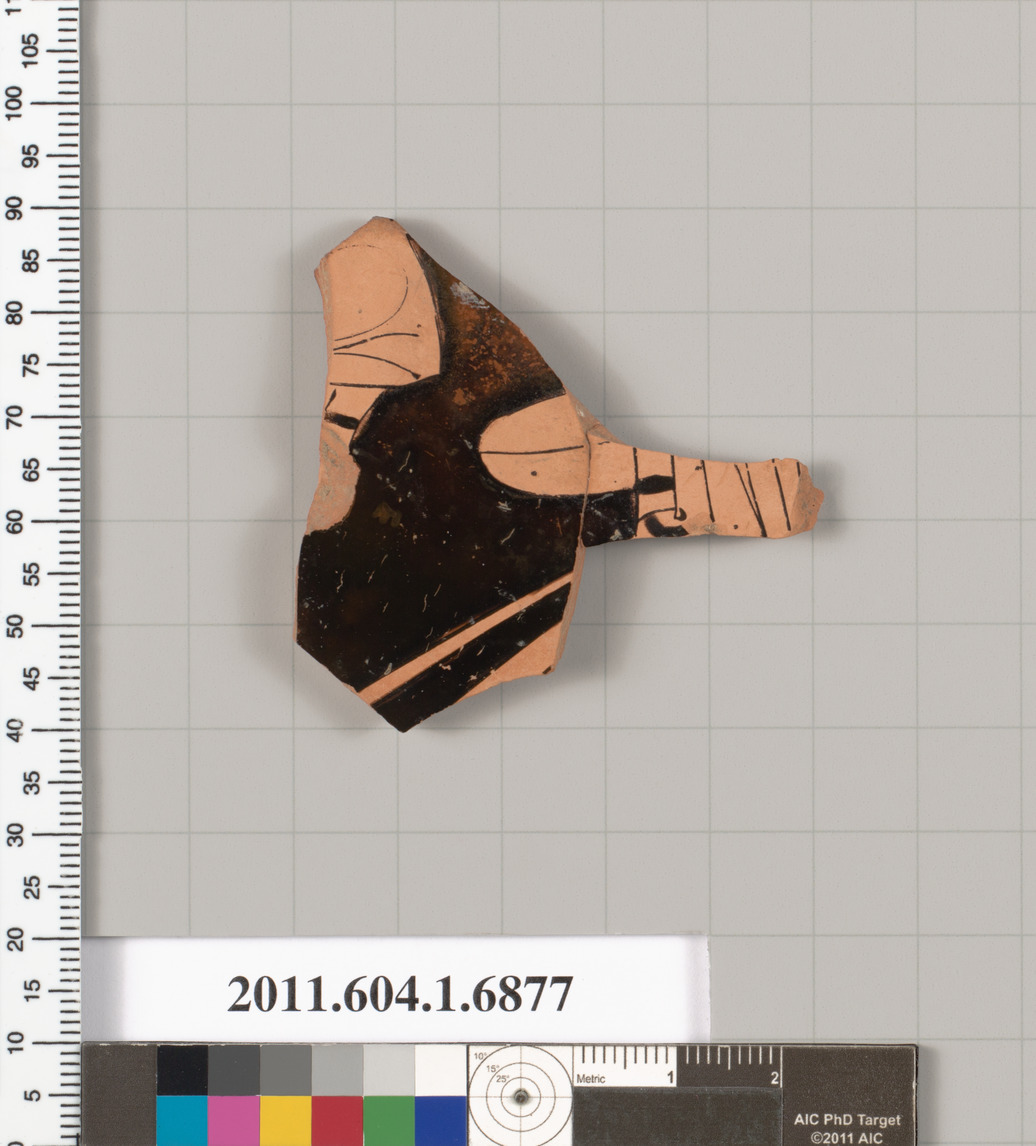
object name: kylix fragment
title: Terracotta fragment of a kylix (drinking cup)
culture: greek, attic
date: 490-470 BCE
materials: terracotta